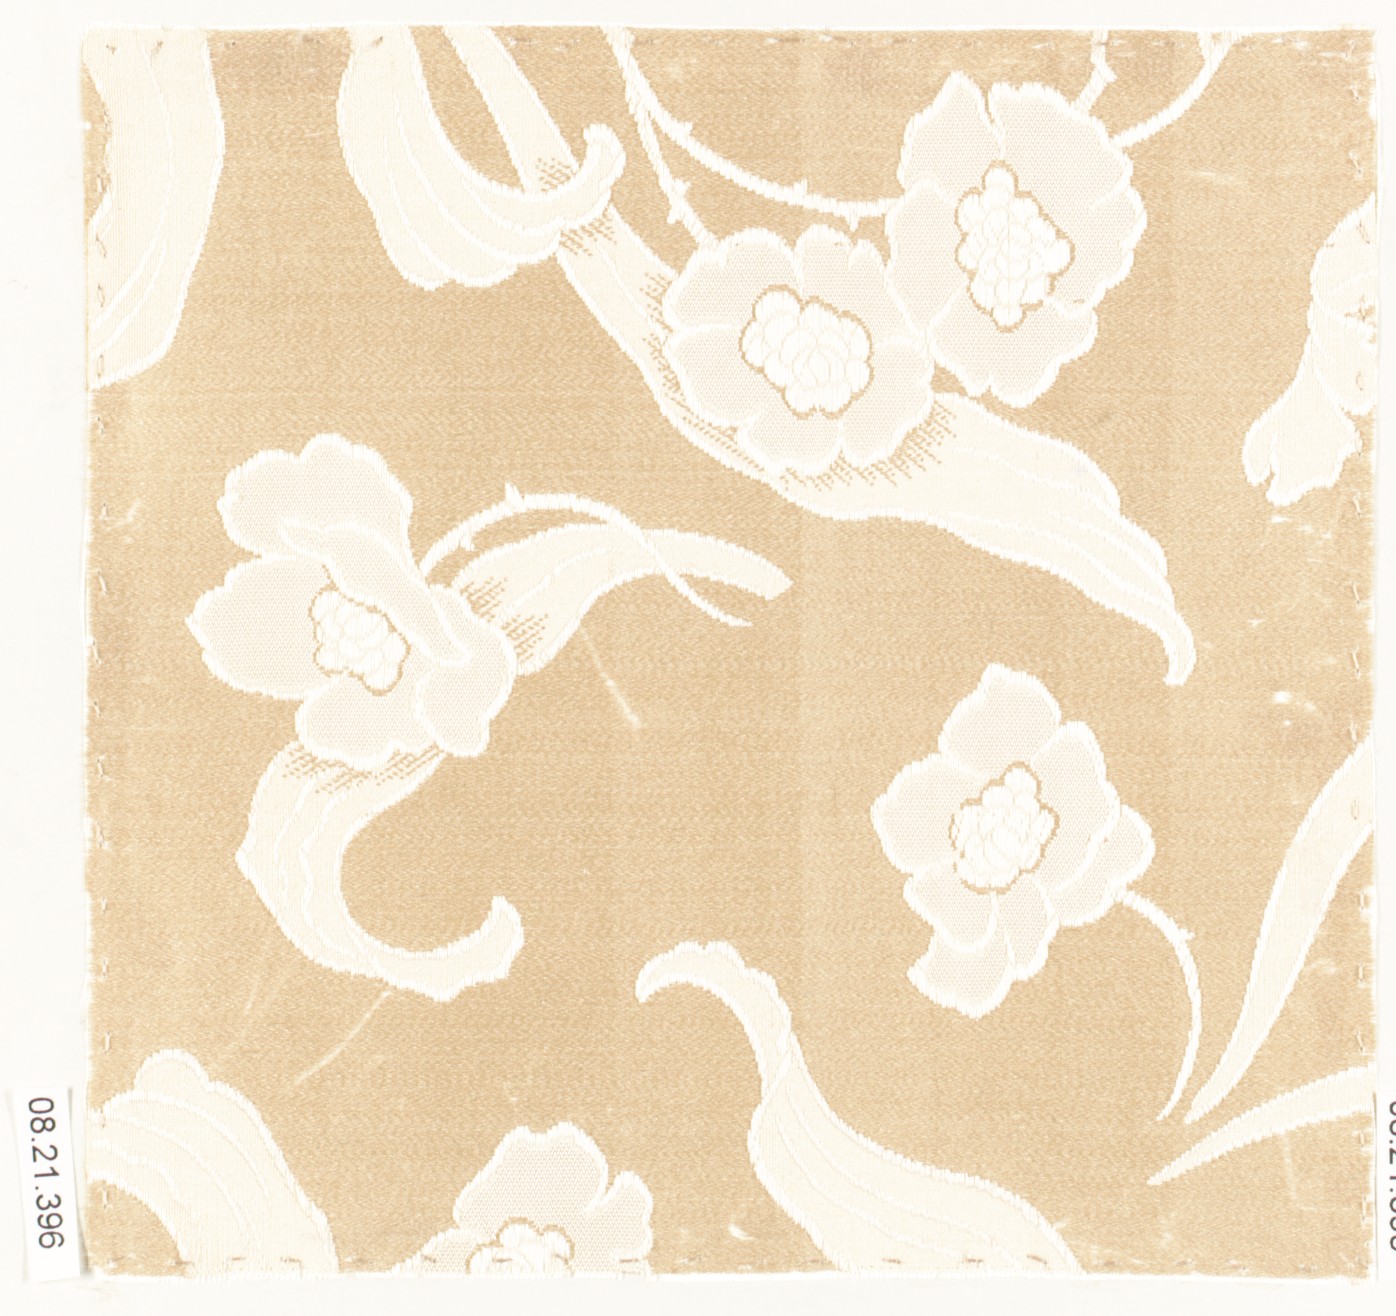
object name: textile sample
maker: Anonymous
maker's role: designer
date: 1900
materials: silk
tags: flowers